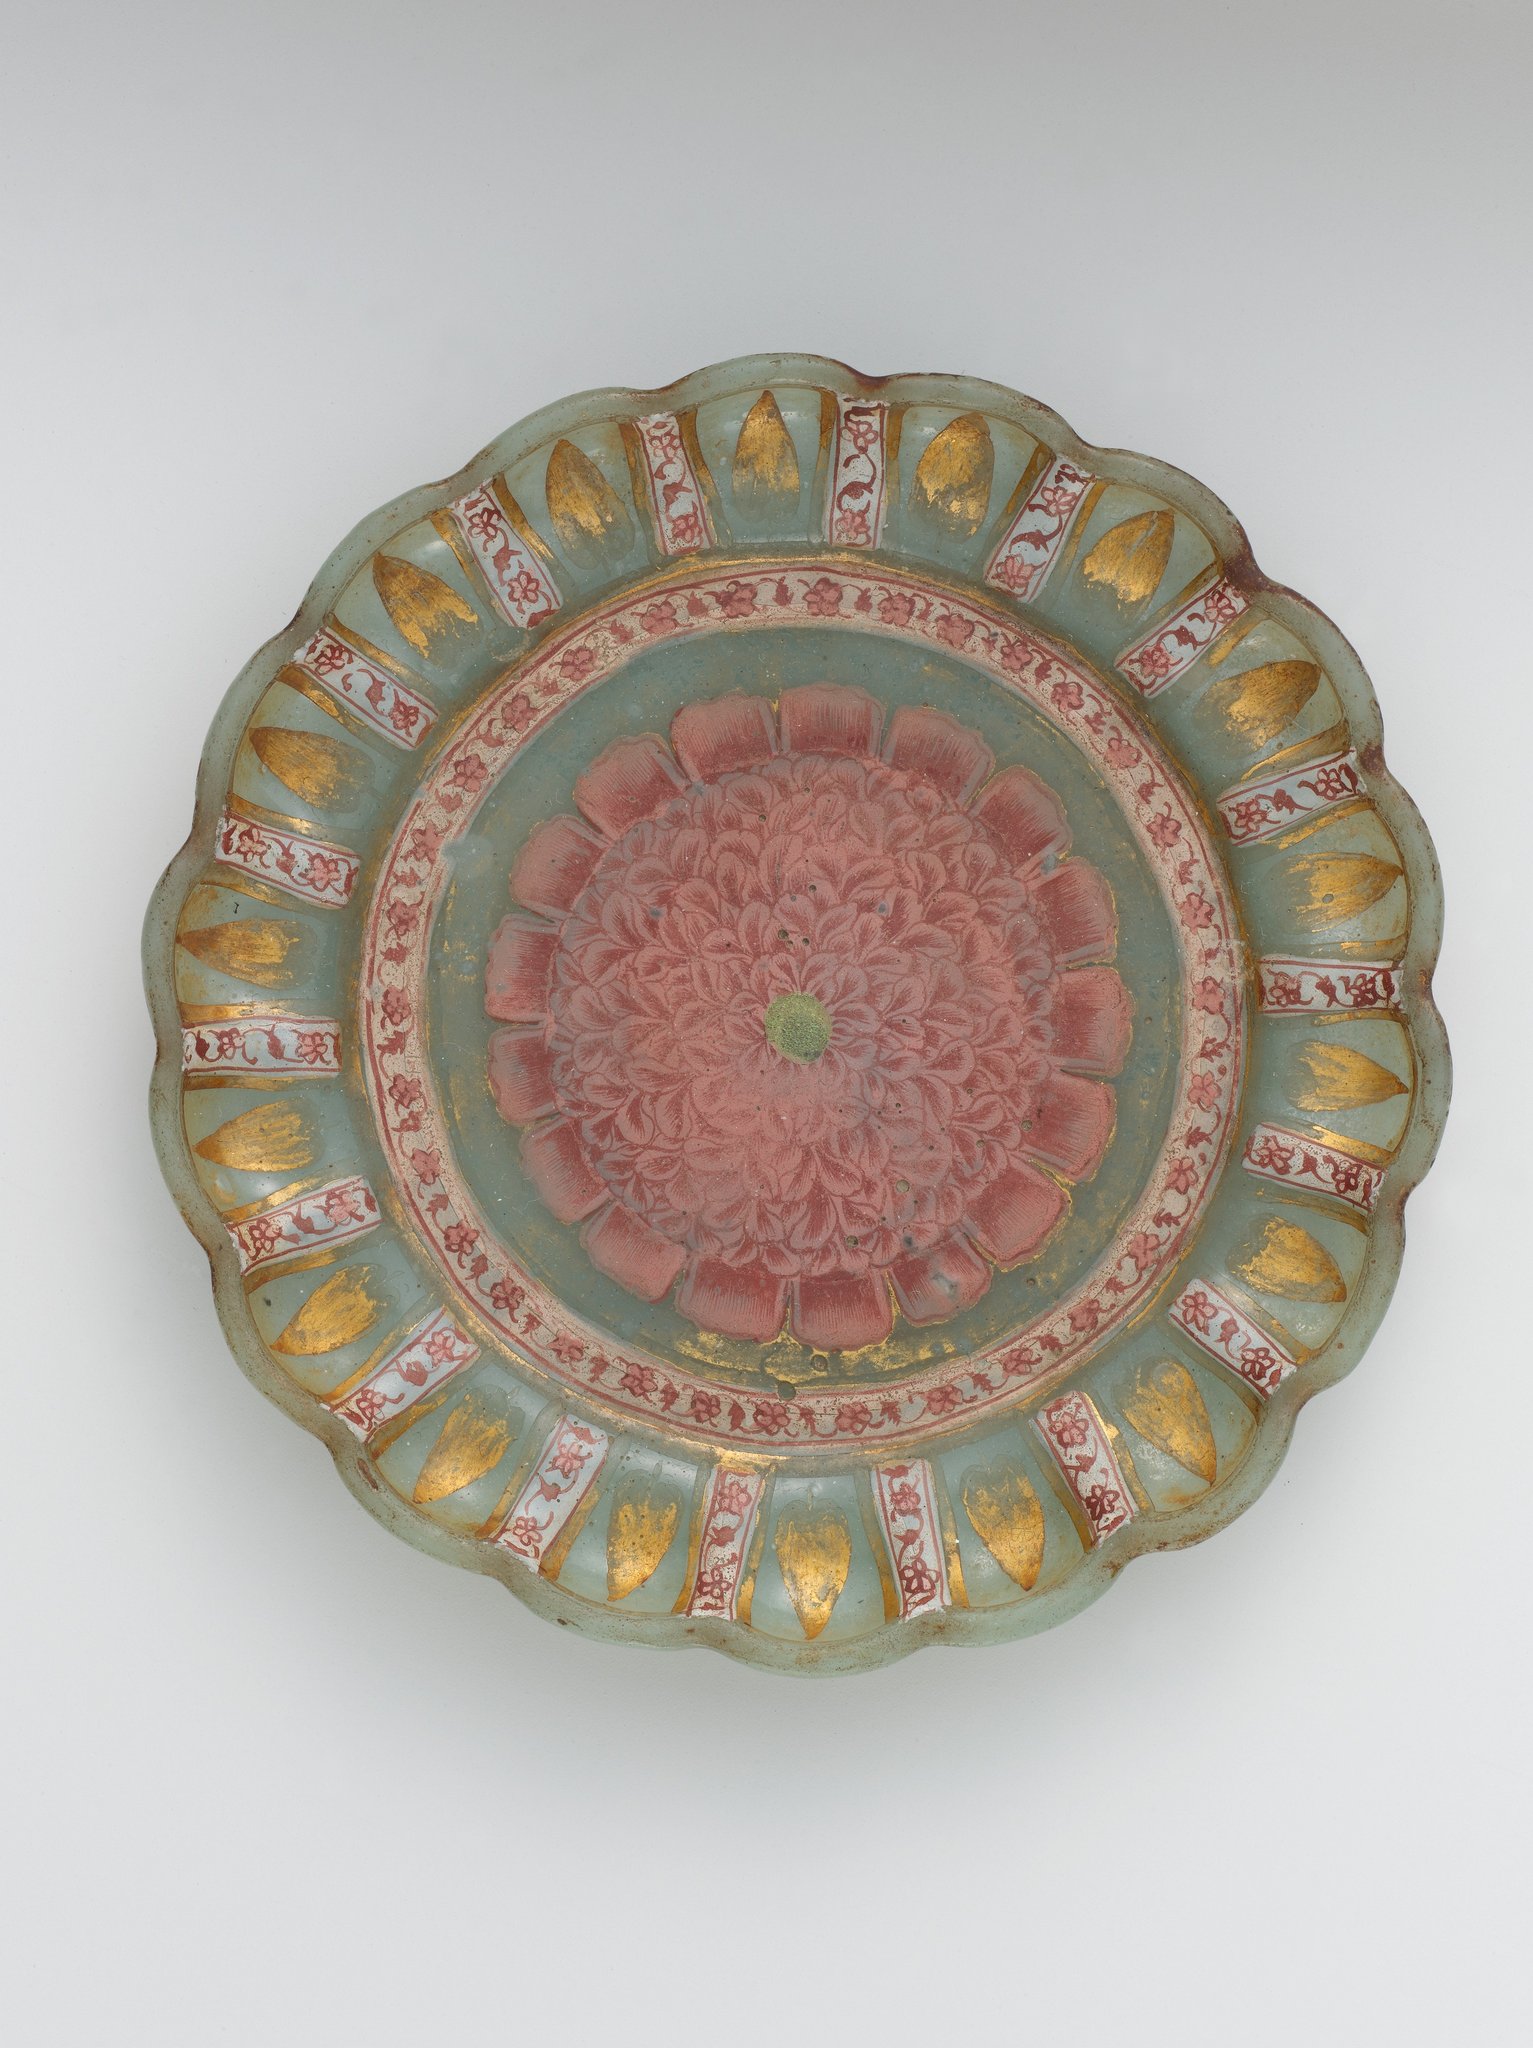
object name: dish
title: Dish with Peony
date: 1667-1733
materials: glass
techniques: glassblowing, enamel, gilding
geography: india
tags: peonies